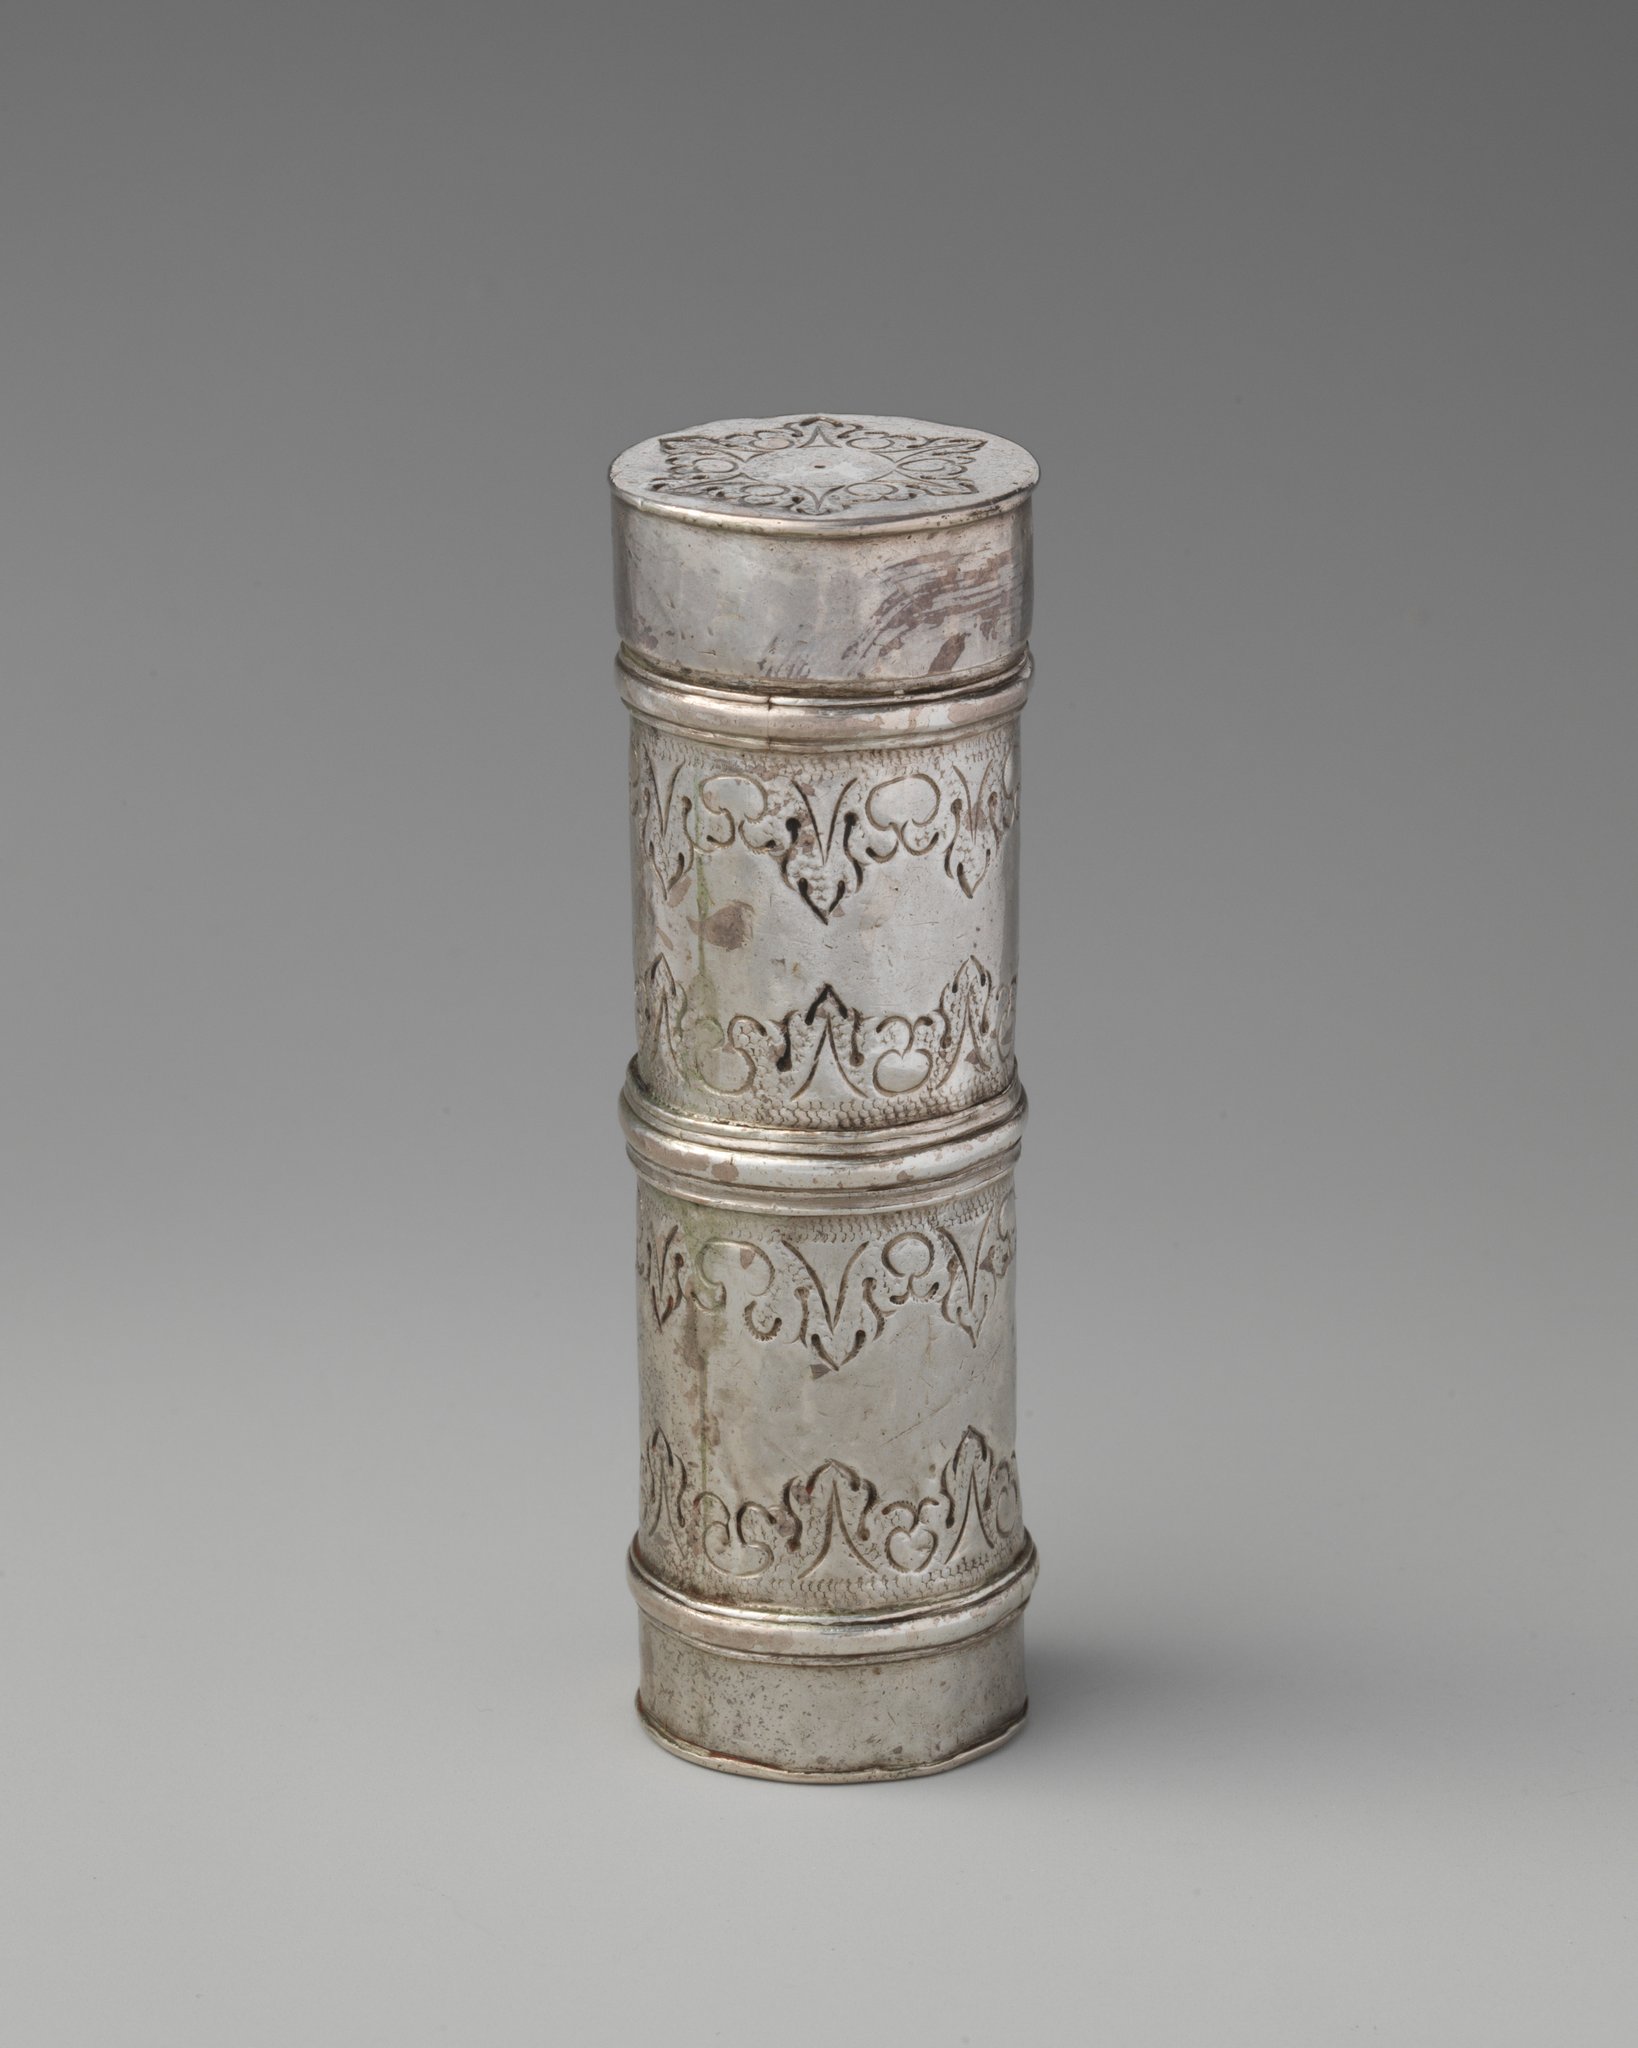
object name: nutmeg grater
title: Miniature nutmeg grater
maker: h.v., london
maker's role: maker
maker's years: 1698-1699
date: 1698-1699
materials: silver